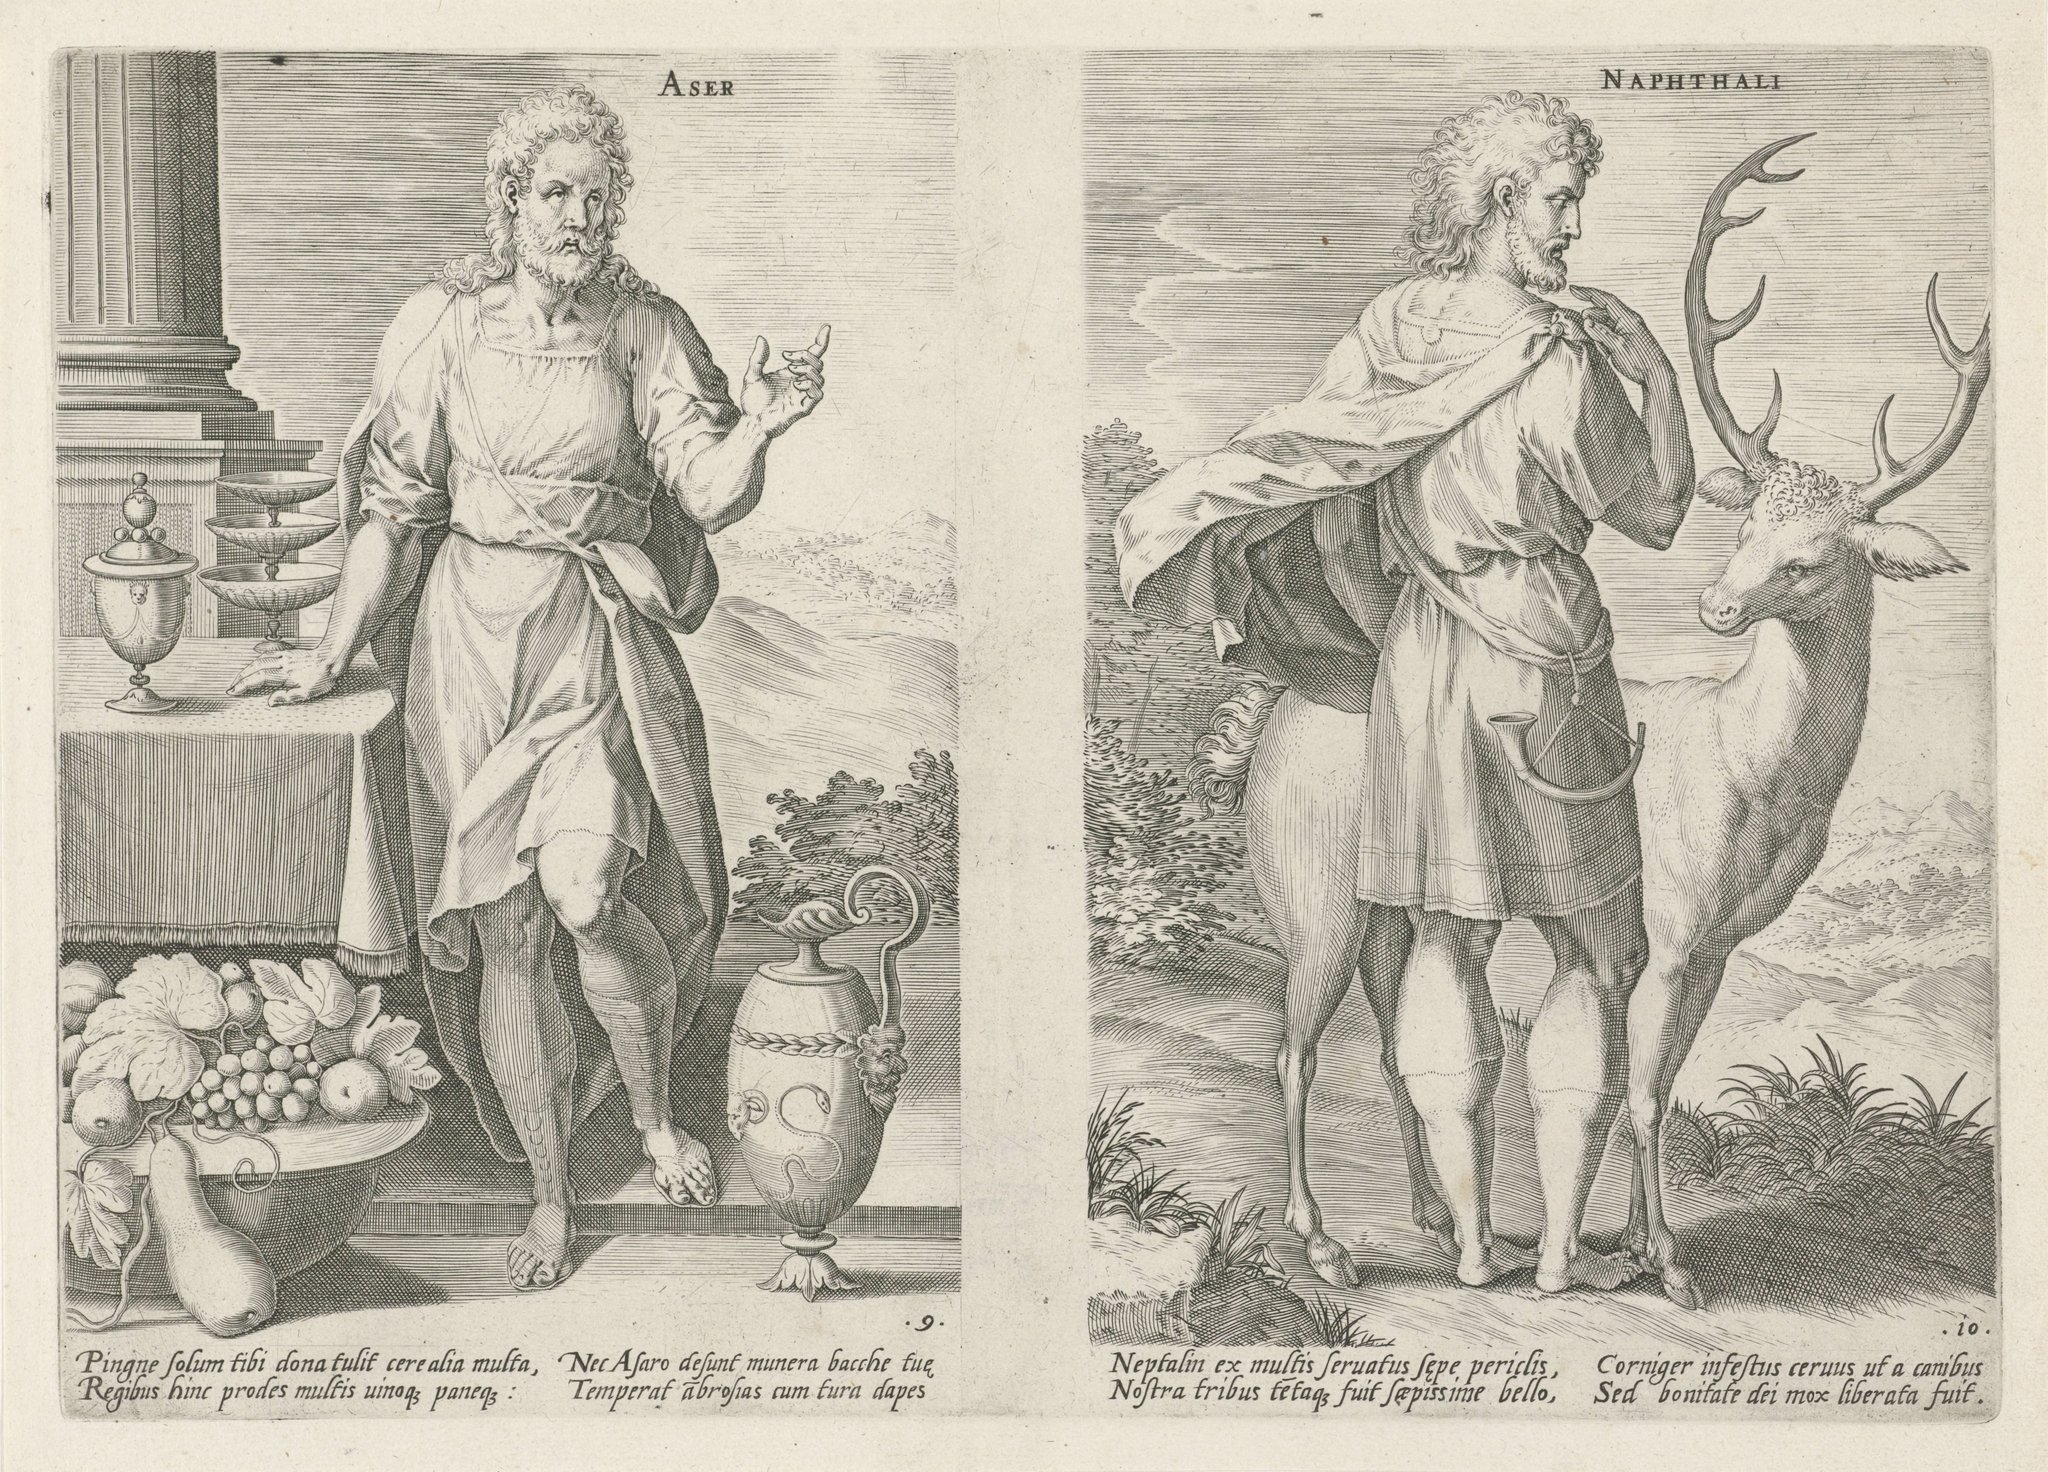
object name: print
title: Stamvaders Aser en Naftali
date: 1579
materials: paper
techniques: engraving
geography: amsterdam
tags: 11i611(naphtali), 11i611(aser)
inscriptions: collector's mark: Lugt 2228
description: Links de stamvader Aser, de achtste zoon van Jakob. Hij staat naast een tafel. Op de grond naast hem een schaal met vruchten en een kruik. Rechts de stamvader Naftali, de zesde zoon van Jakob. Naast hem een hert, verwijzend naar Naftali's snelheid. Elke afbeelding heeft een Latijns onderschrift en het blad bevat de negende en achtste prent uit een serie met als onderwerp de twaalf stamvaders van Israël.